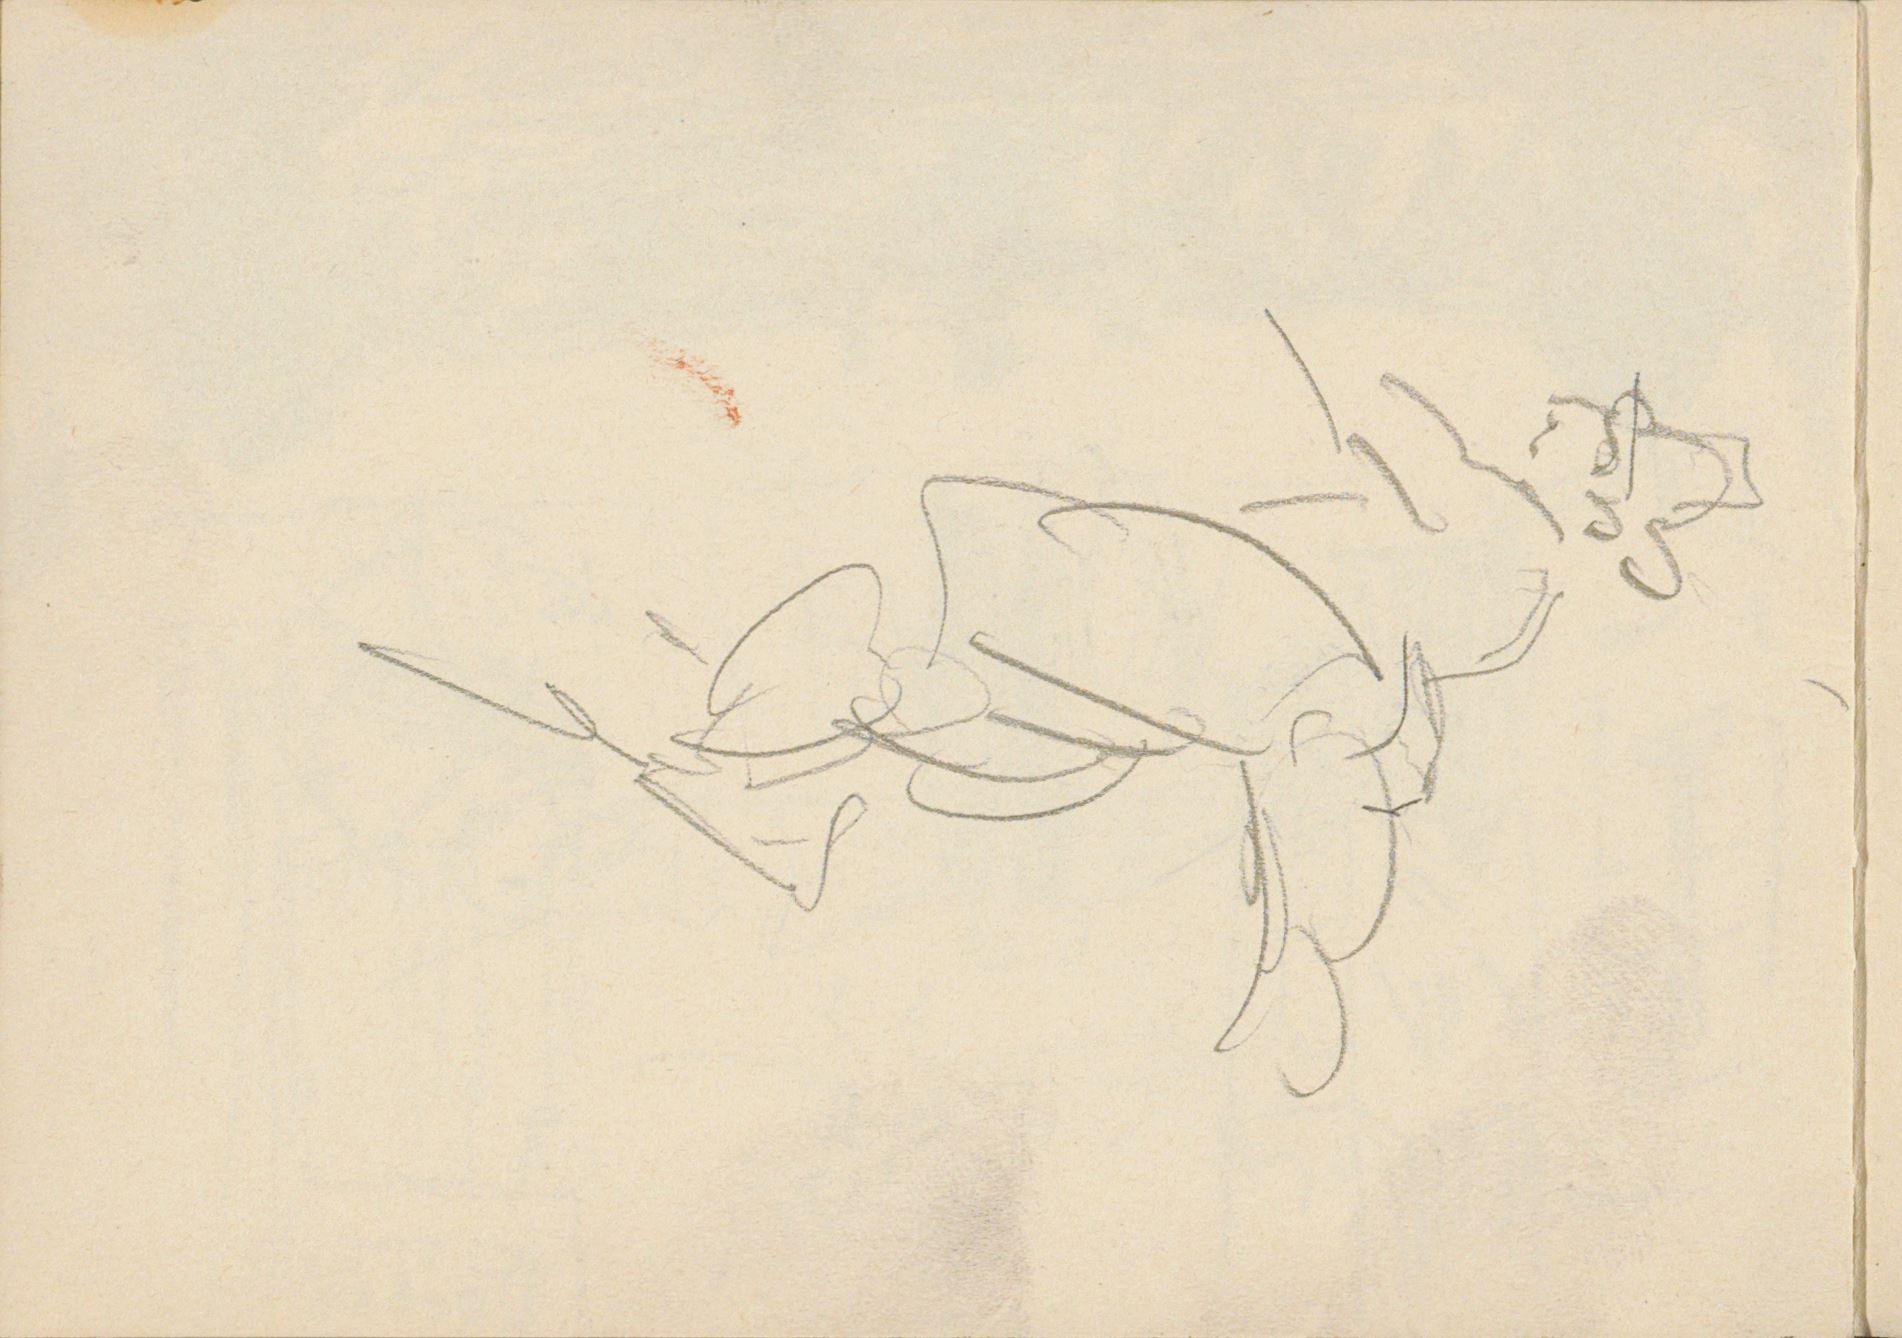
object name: sketchbook leaf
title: Figuurstudies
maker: isaac israels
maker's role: draughtsman, painter, print maker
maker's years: 1865-1934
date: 1930-1934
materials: paper, pencil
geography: the hague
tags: the (nude) human figure; 'corpo humano' (ripa)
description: Pagina 15 uit schetsboek XXXVIII met 45 pagina's.